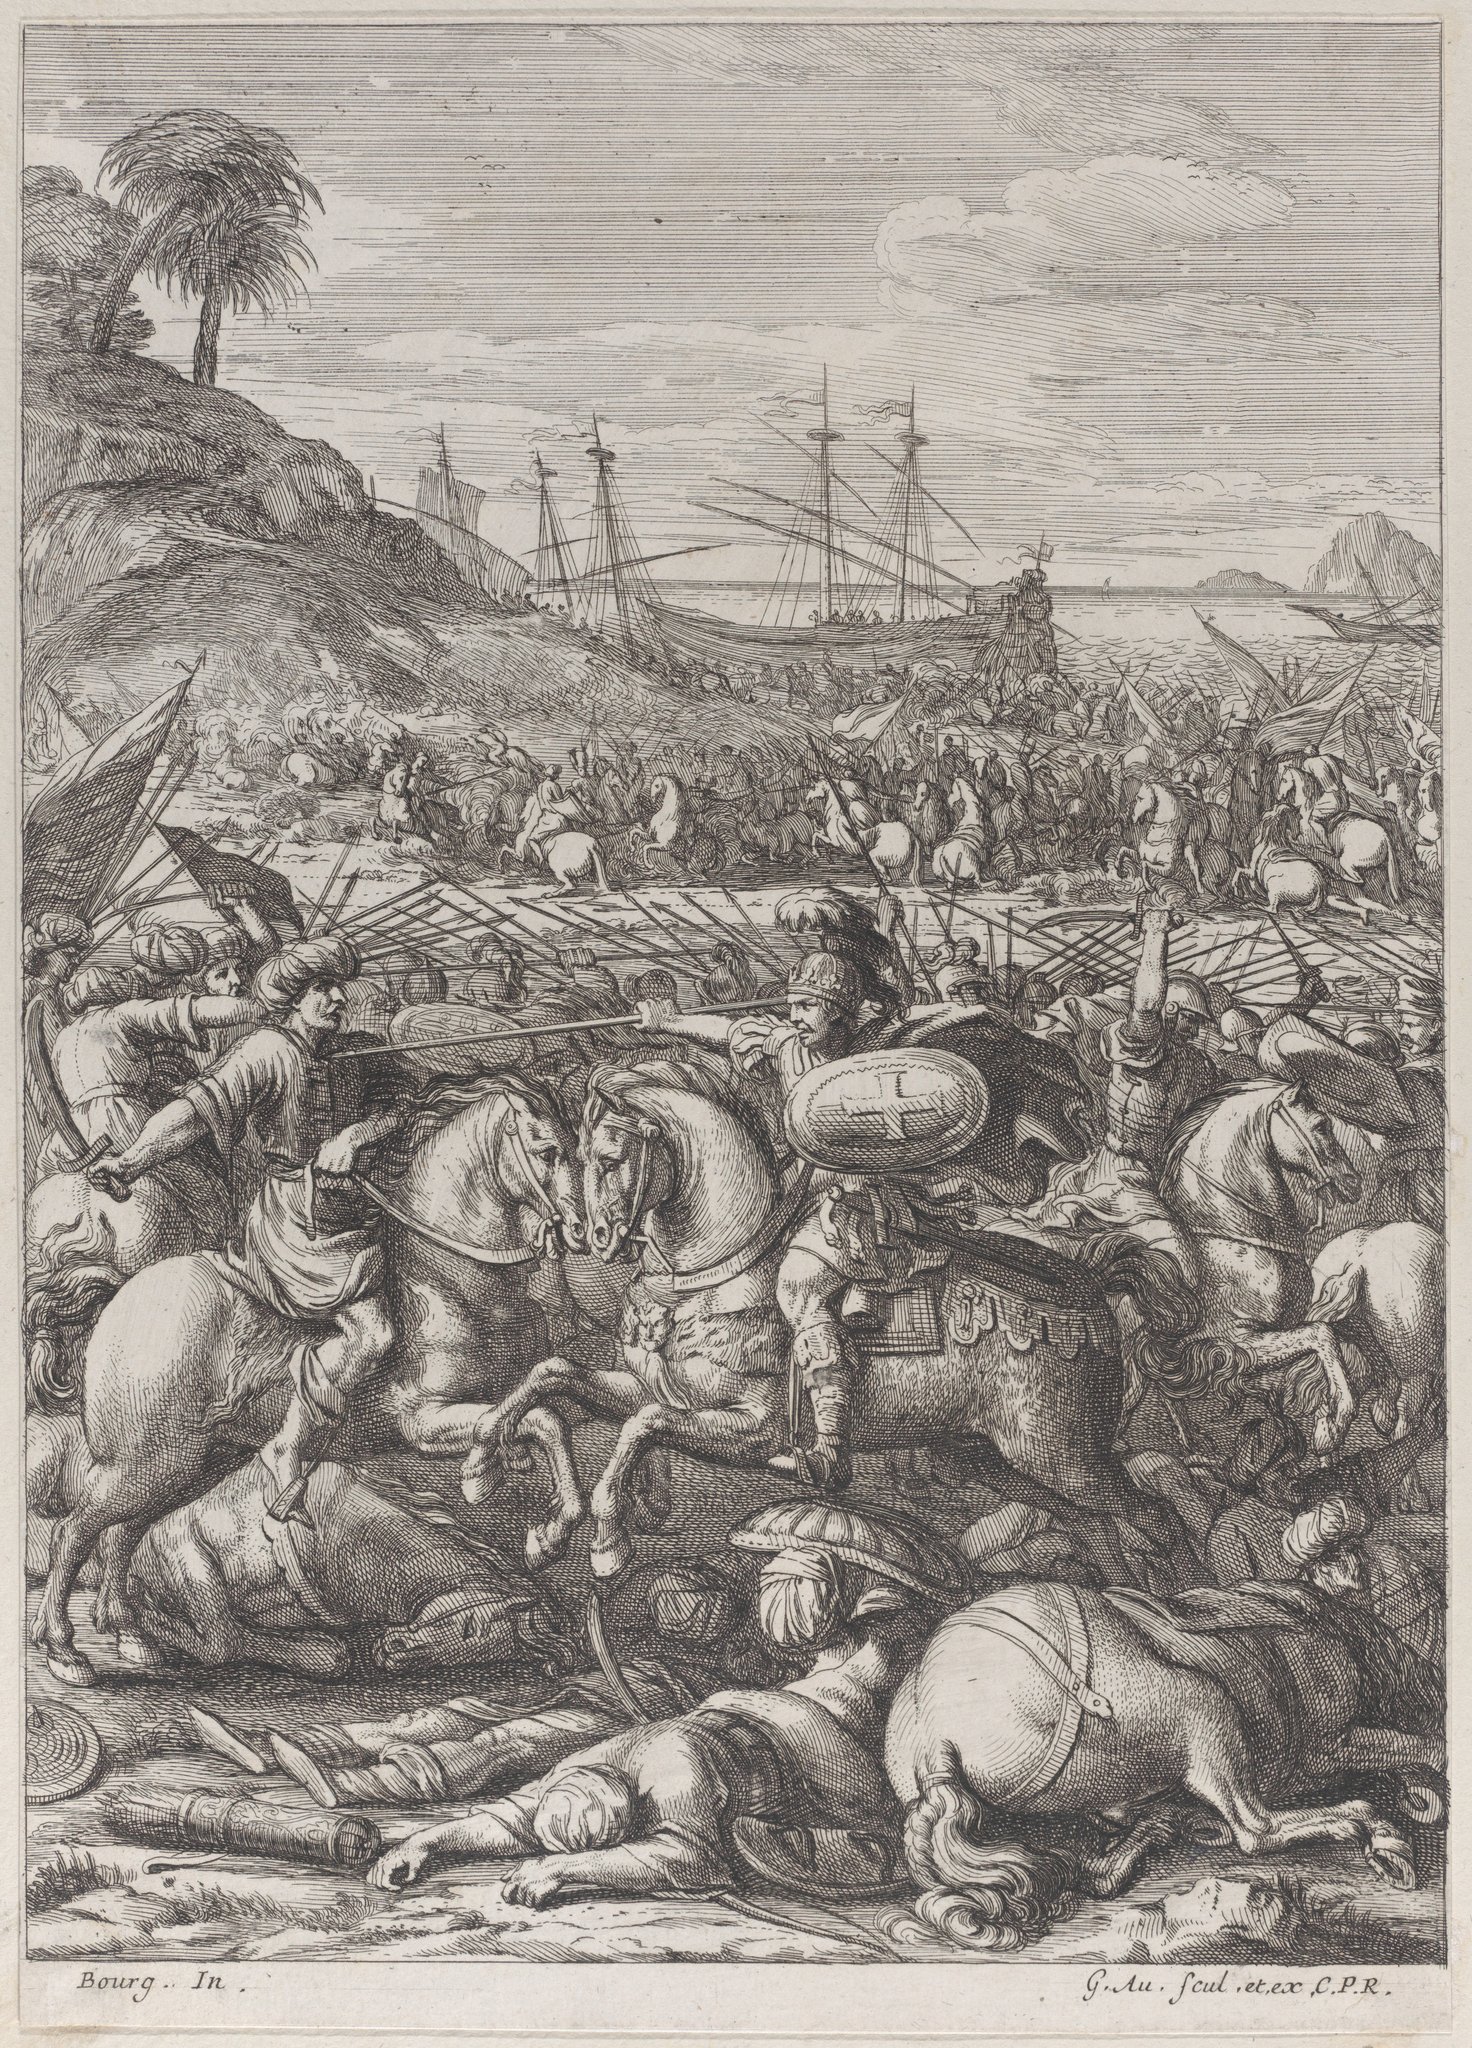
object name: print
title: The Battle of Antioch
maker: girard audran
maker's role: artist and publisher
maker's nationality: french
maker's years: 1640-1703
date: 1672-1678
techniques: etching